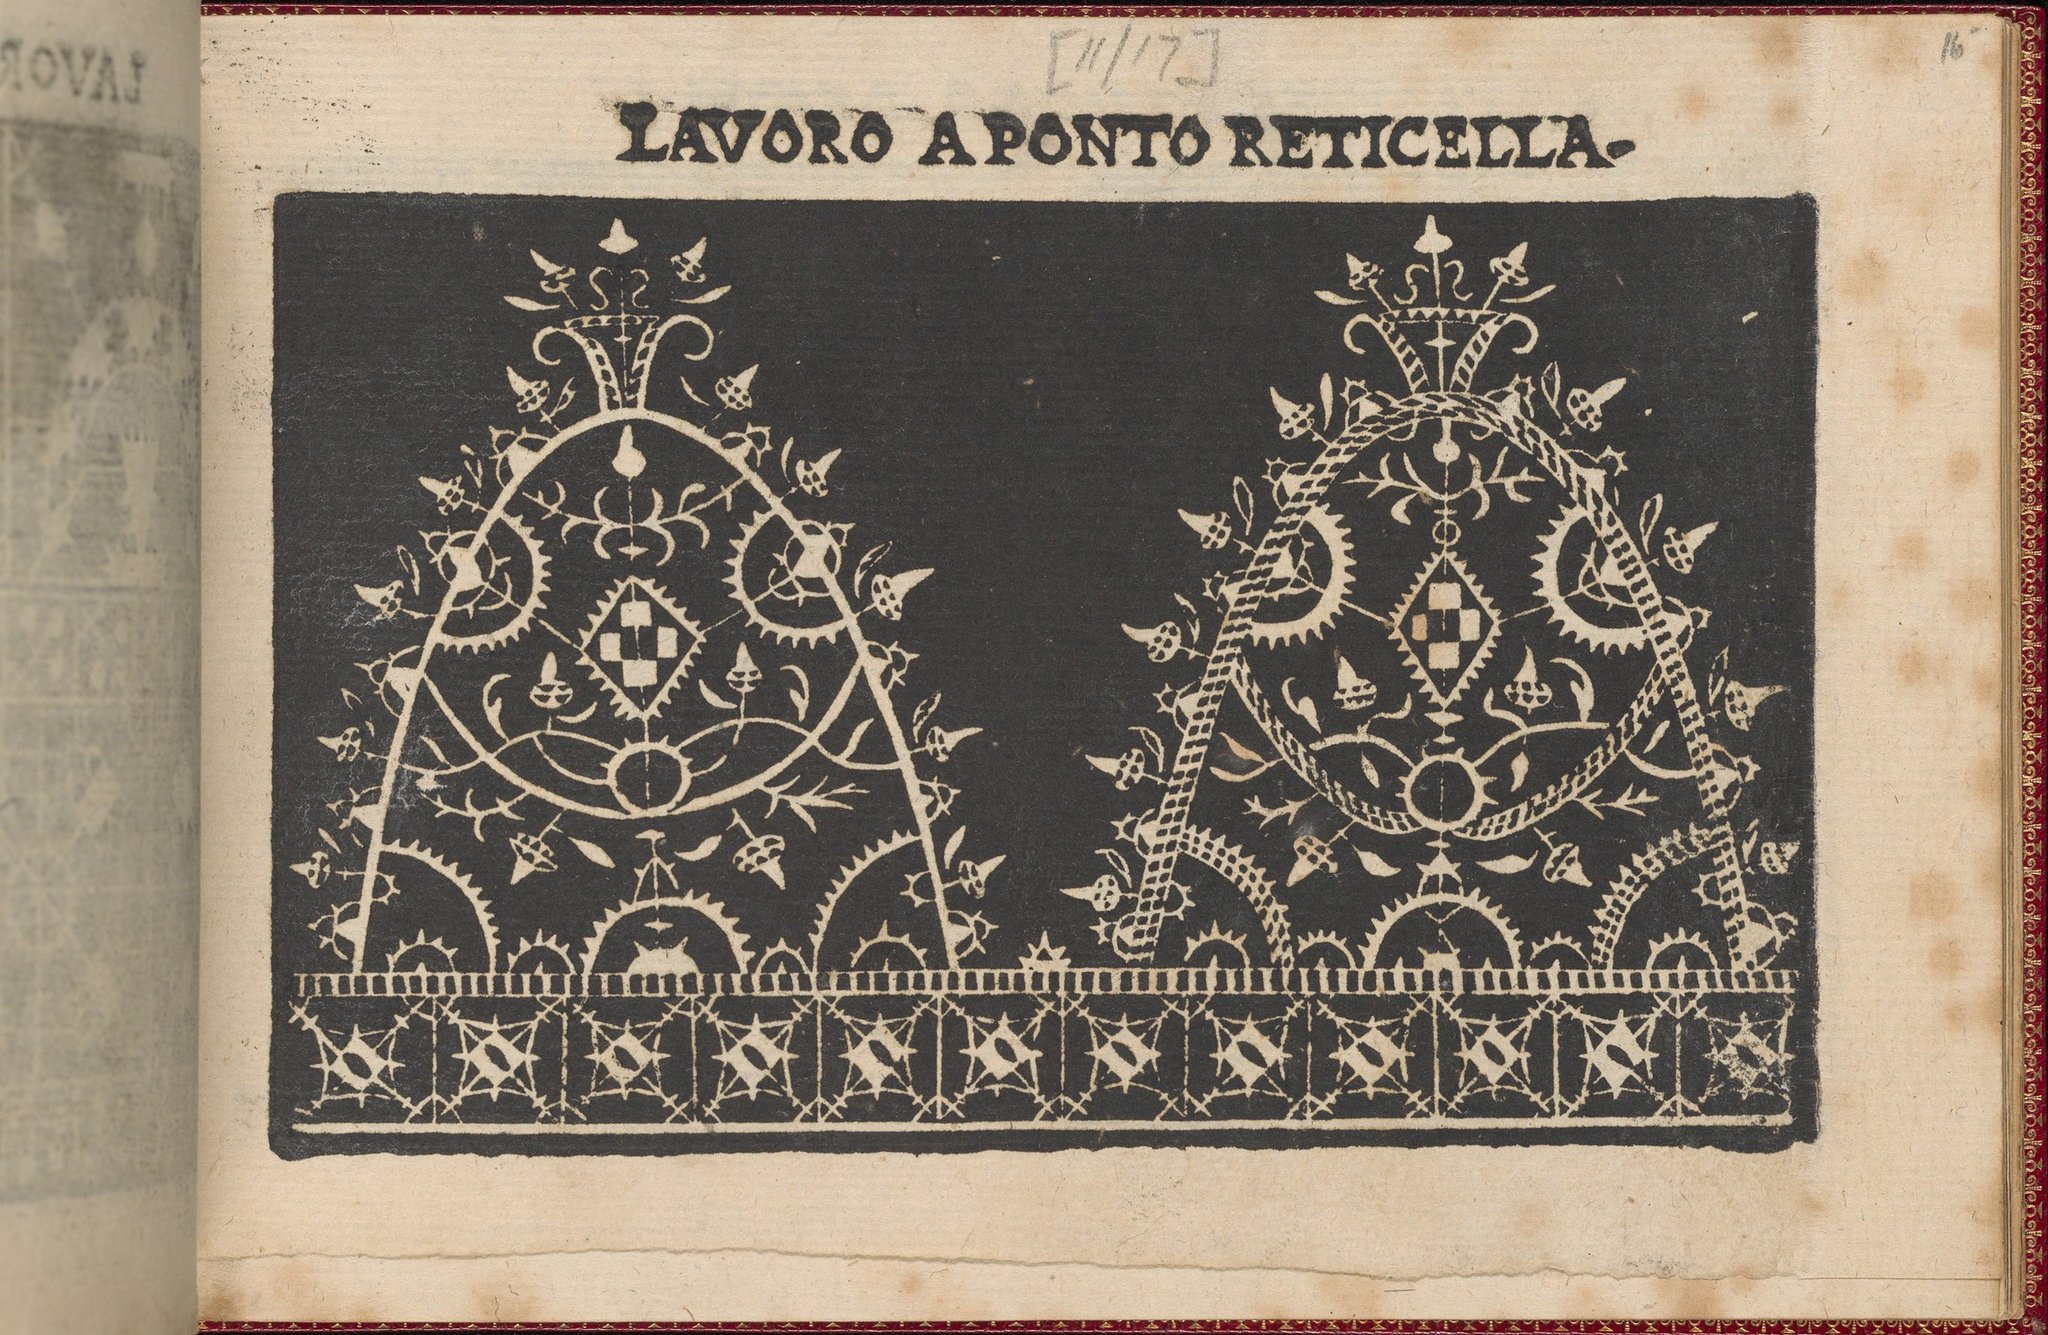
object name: book print ornament architecture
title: Pretiosa Gemma delle virtuose donne, page 18 (recto)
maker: isabella catanea parasole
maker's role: author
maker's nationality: italian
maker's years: 1565-1625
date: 1600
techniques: woodcut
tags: ornament